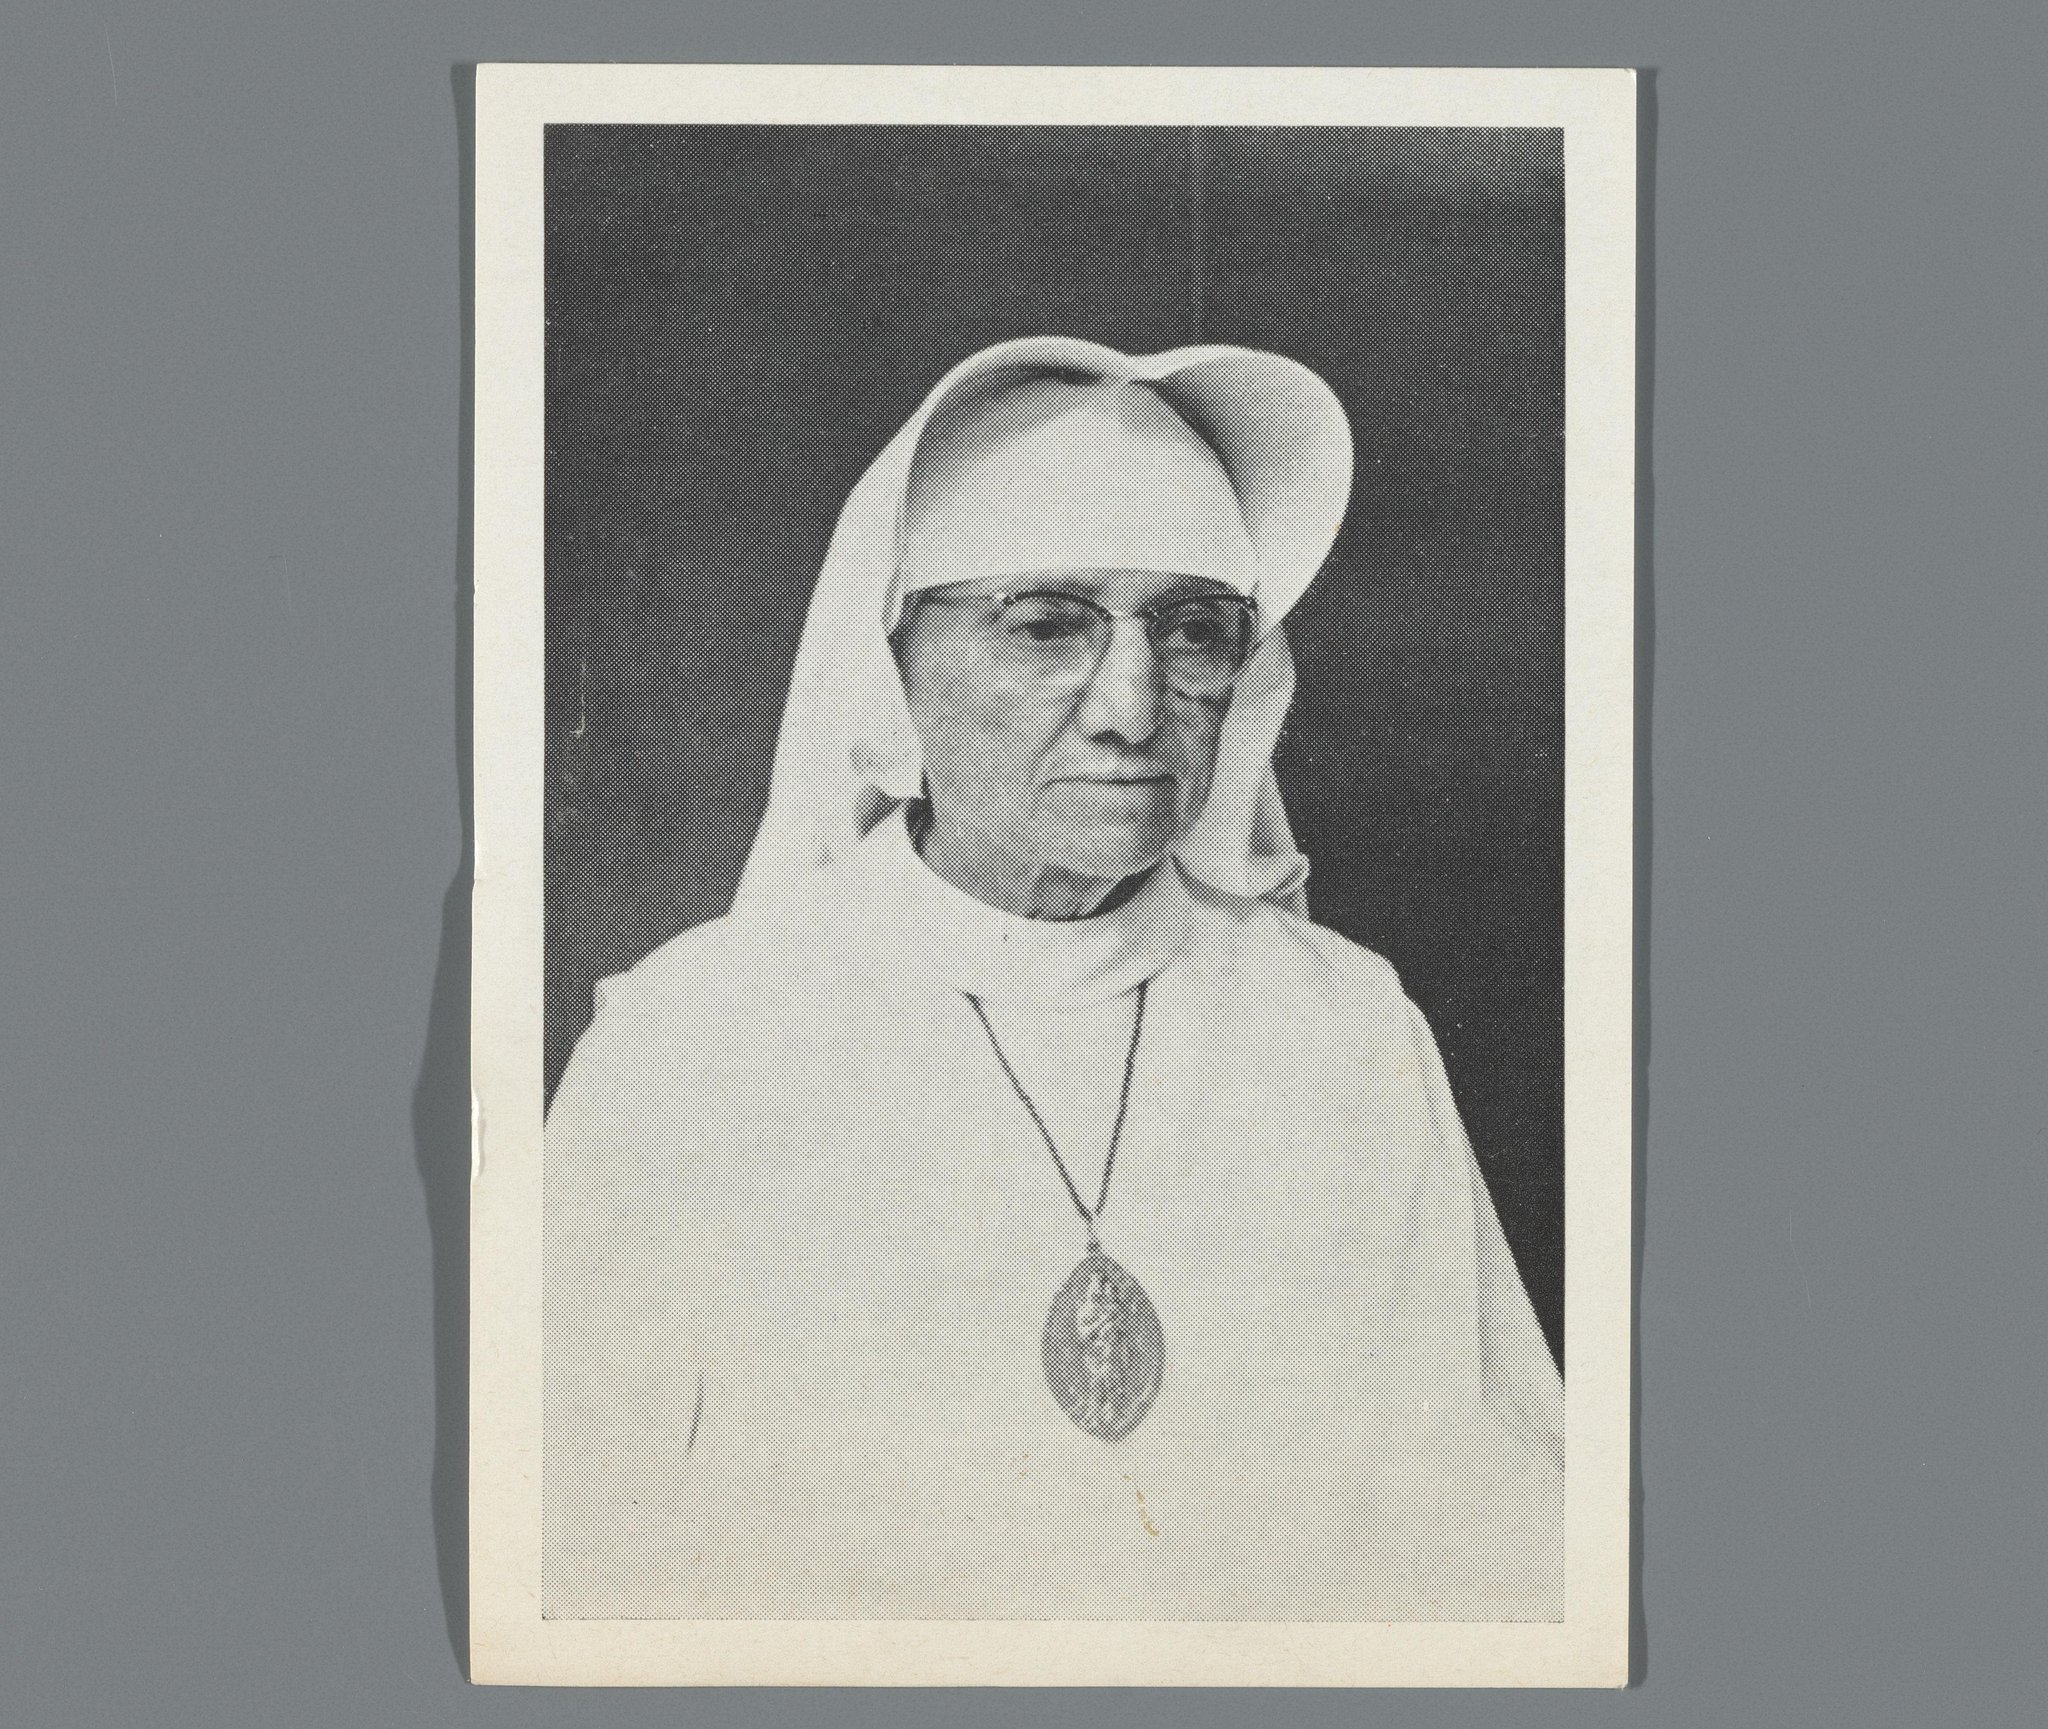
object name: photomechanical print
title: Portret van zuster Tarcies Mathilde Bogaers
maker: Anonymous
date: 1971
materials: paper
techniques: autotype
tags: historical persons - bb - woman